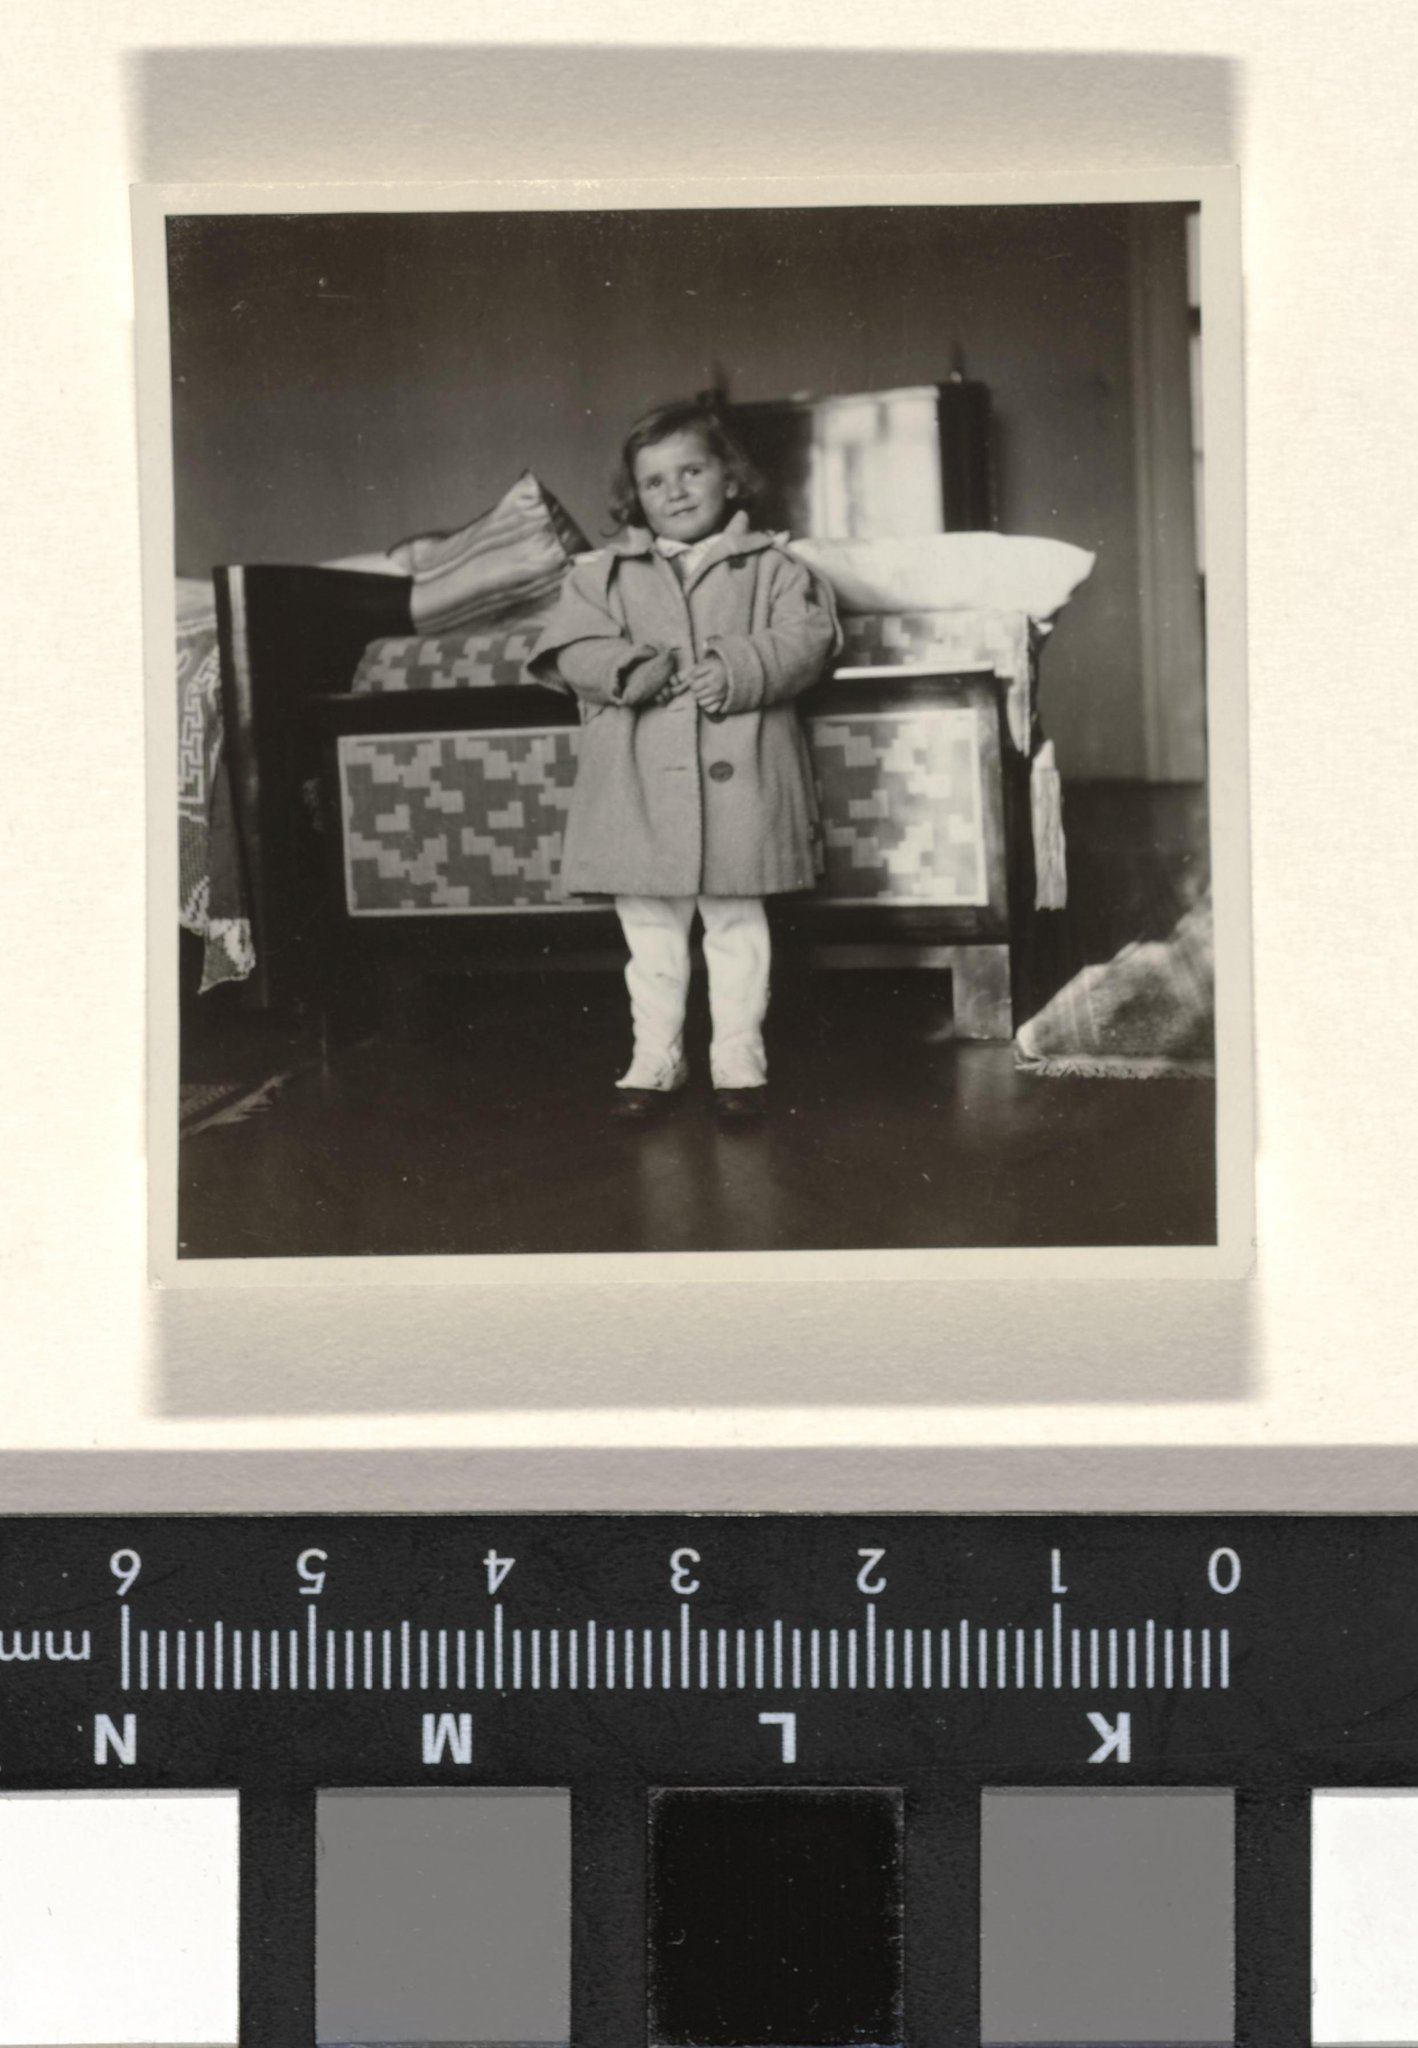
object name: photograph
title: Isabel Wachenheimer voor een bed, maart 1931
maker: Anonymous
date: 1903-1931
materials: photographic support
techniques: gelatin silver print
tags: leiden, isabel wachenheimer-elon